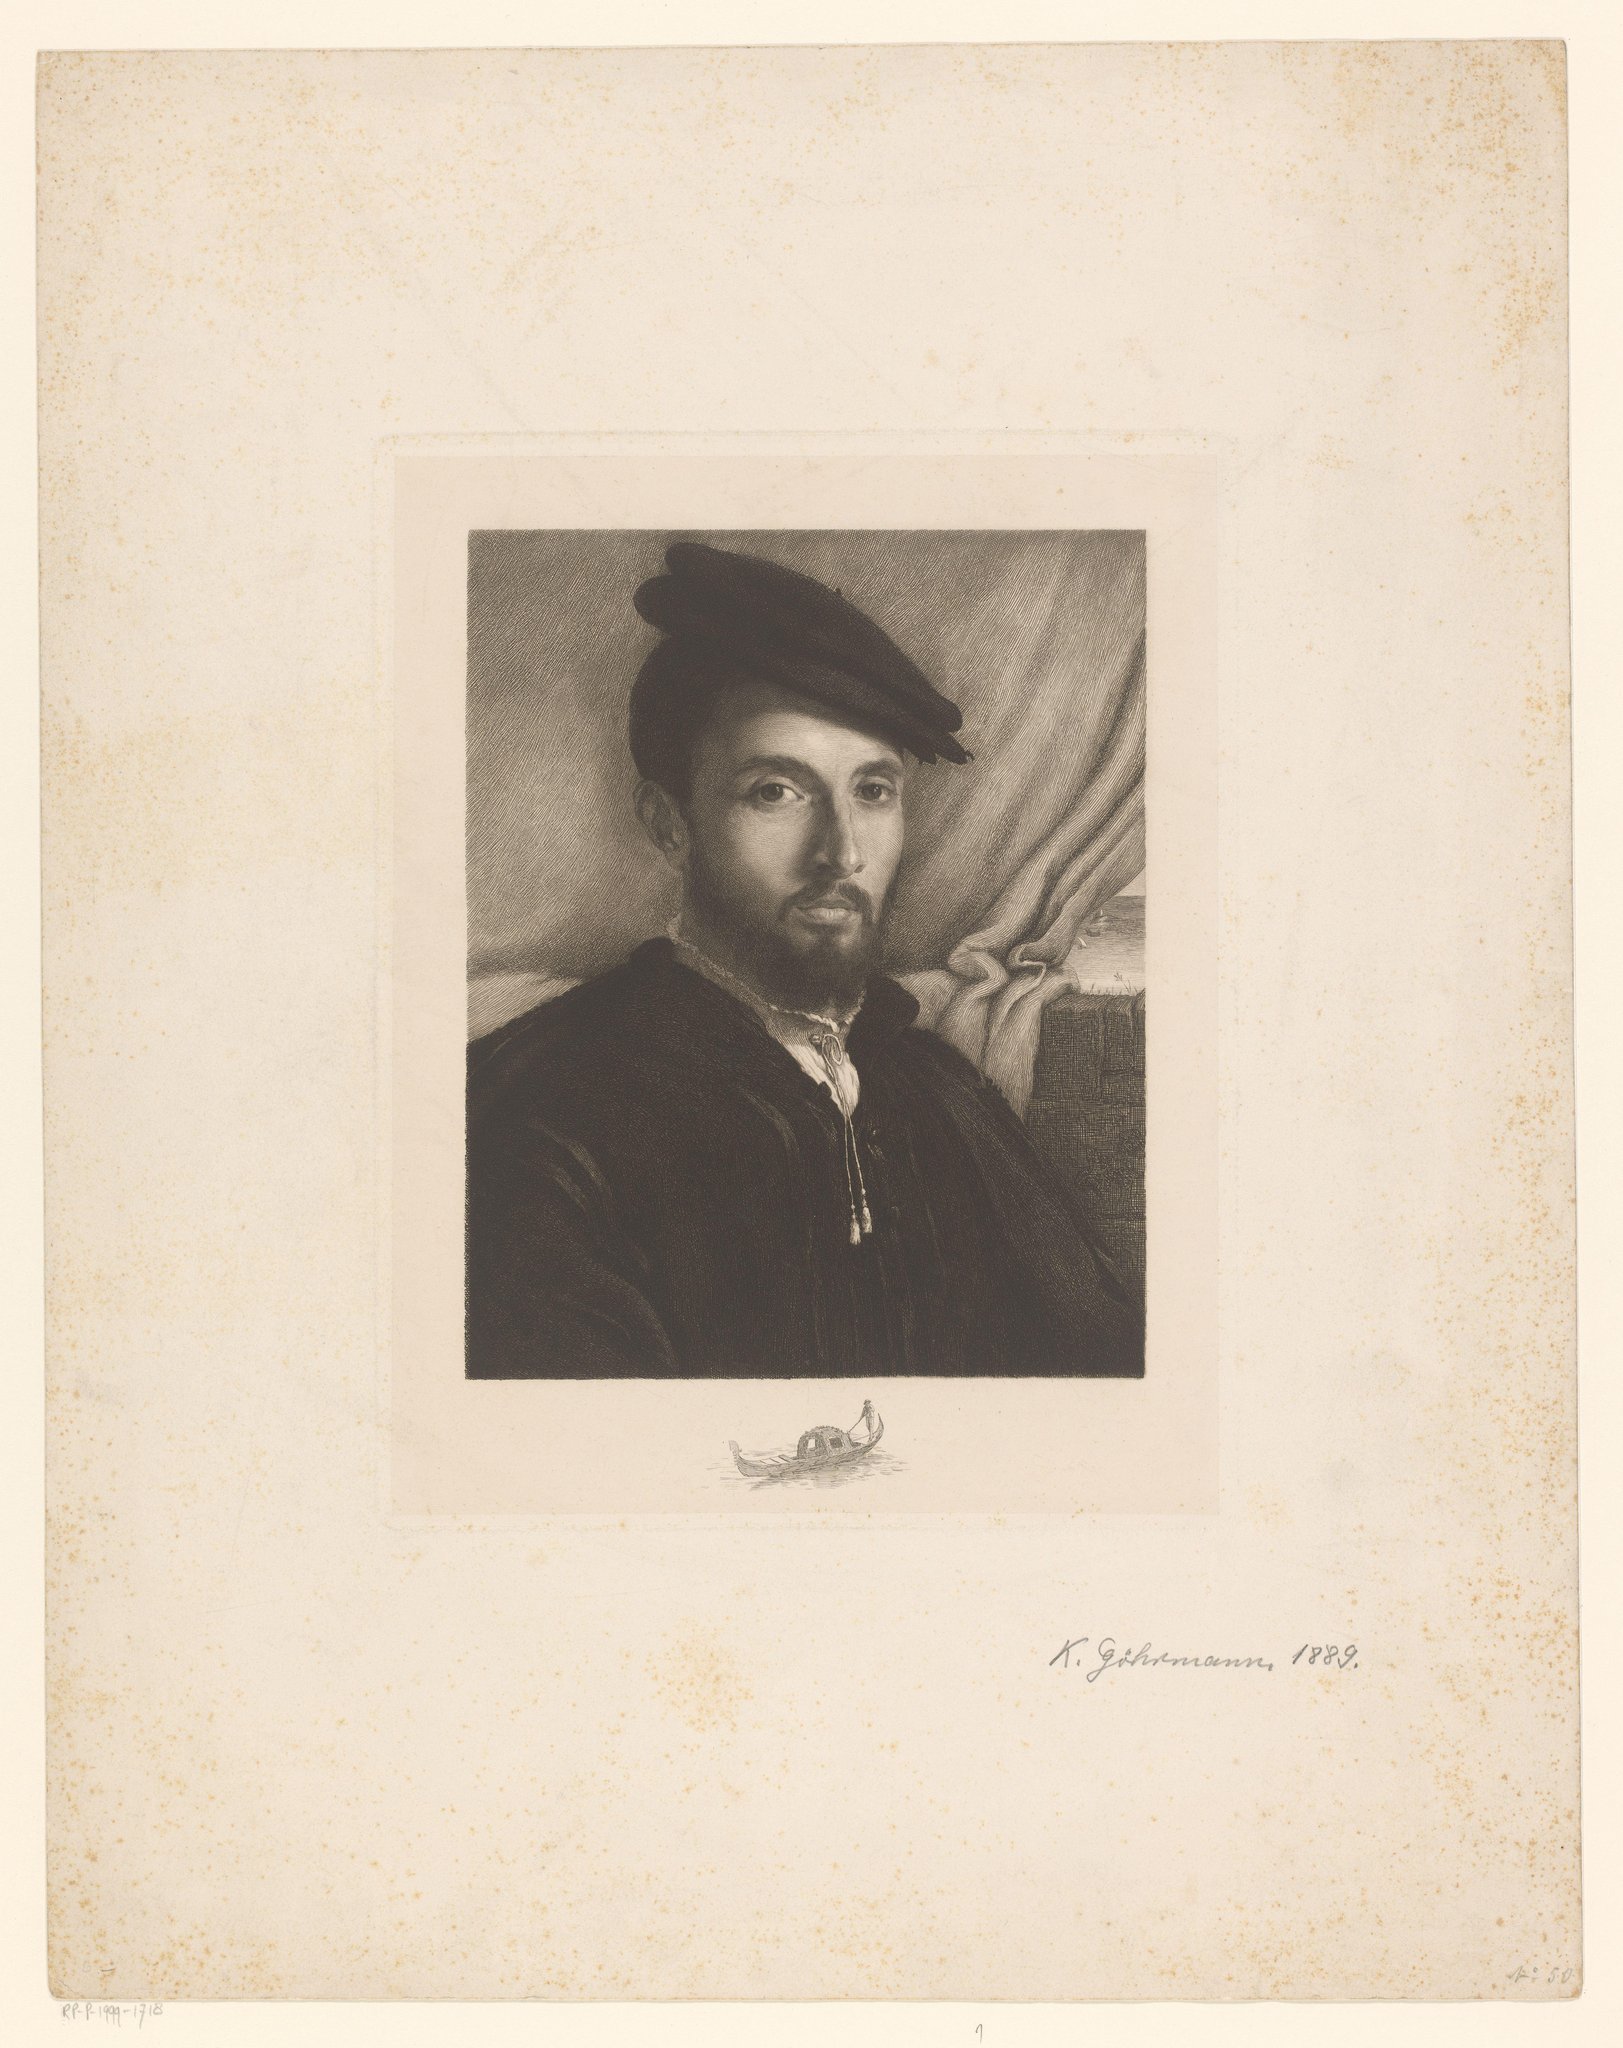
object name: print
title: Portret van een onbekende man met baret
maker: k. göhrmann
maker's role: print maker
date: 1889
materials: paper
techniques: etching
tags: anonymous historical person portrayed alone, head-gear: beret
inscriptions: collector's mark: Lugt 2228, inscription: ‘K. Göhrmann, 1889’